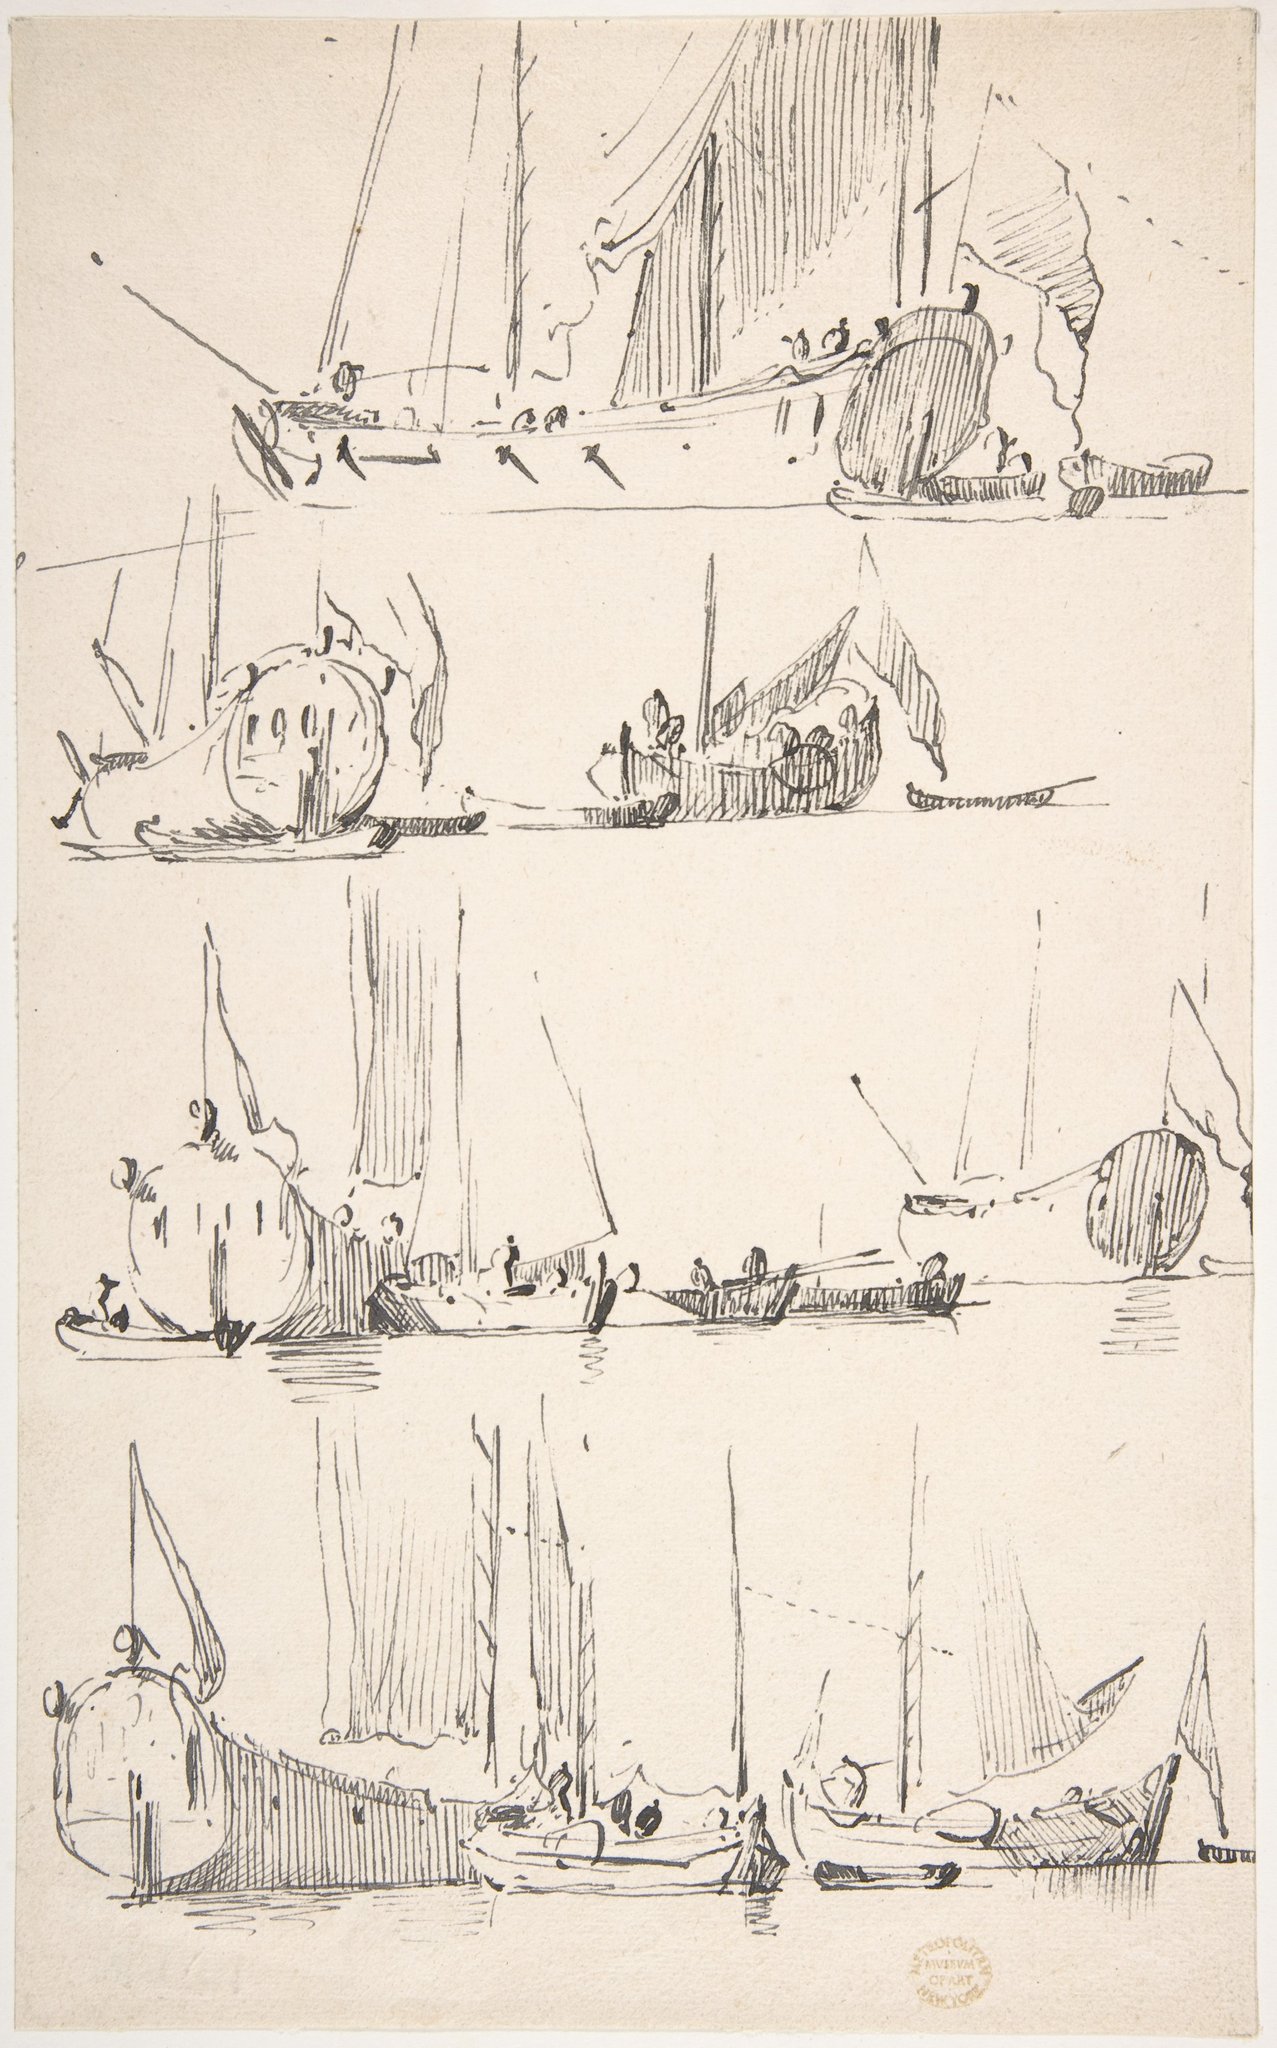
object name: drawing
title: Studies of Ships and Boats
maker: willem van de velde (ii)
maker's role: artist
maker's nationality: dutch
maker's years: 1633-1707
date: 1634-1733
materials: ink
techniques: pen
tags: boats,ships